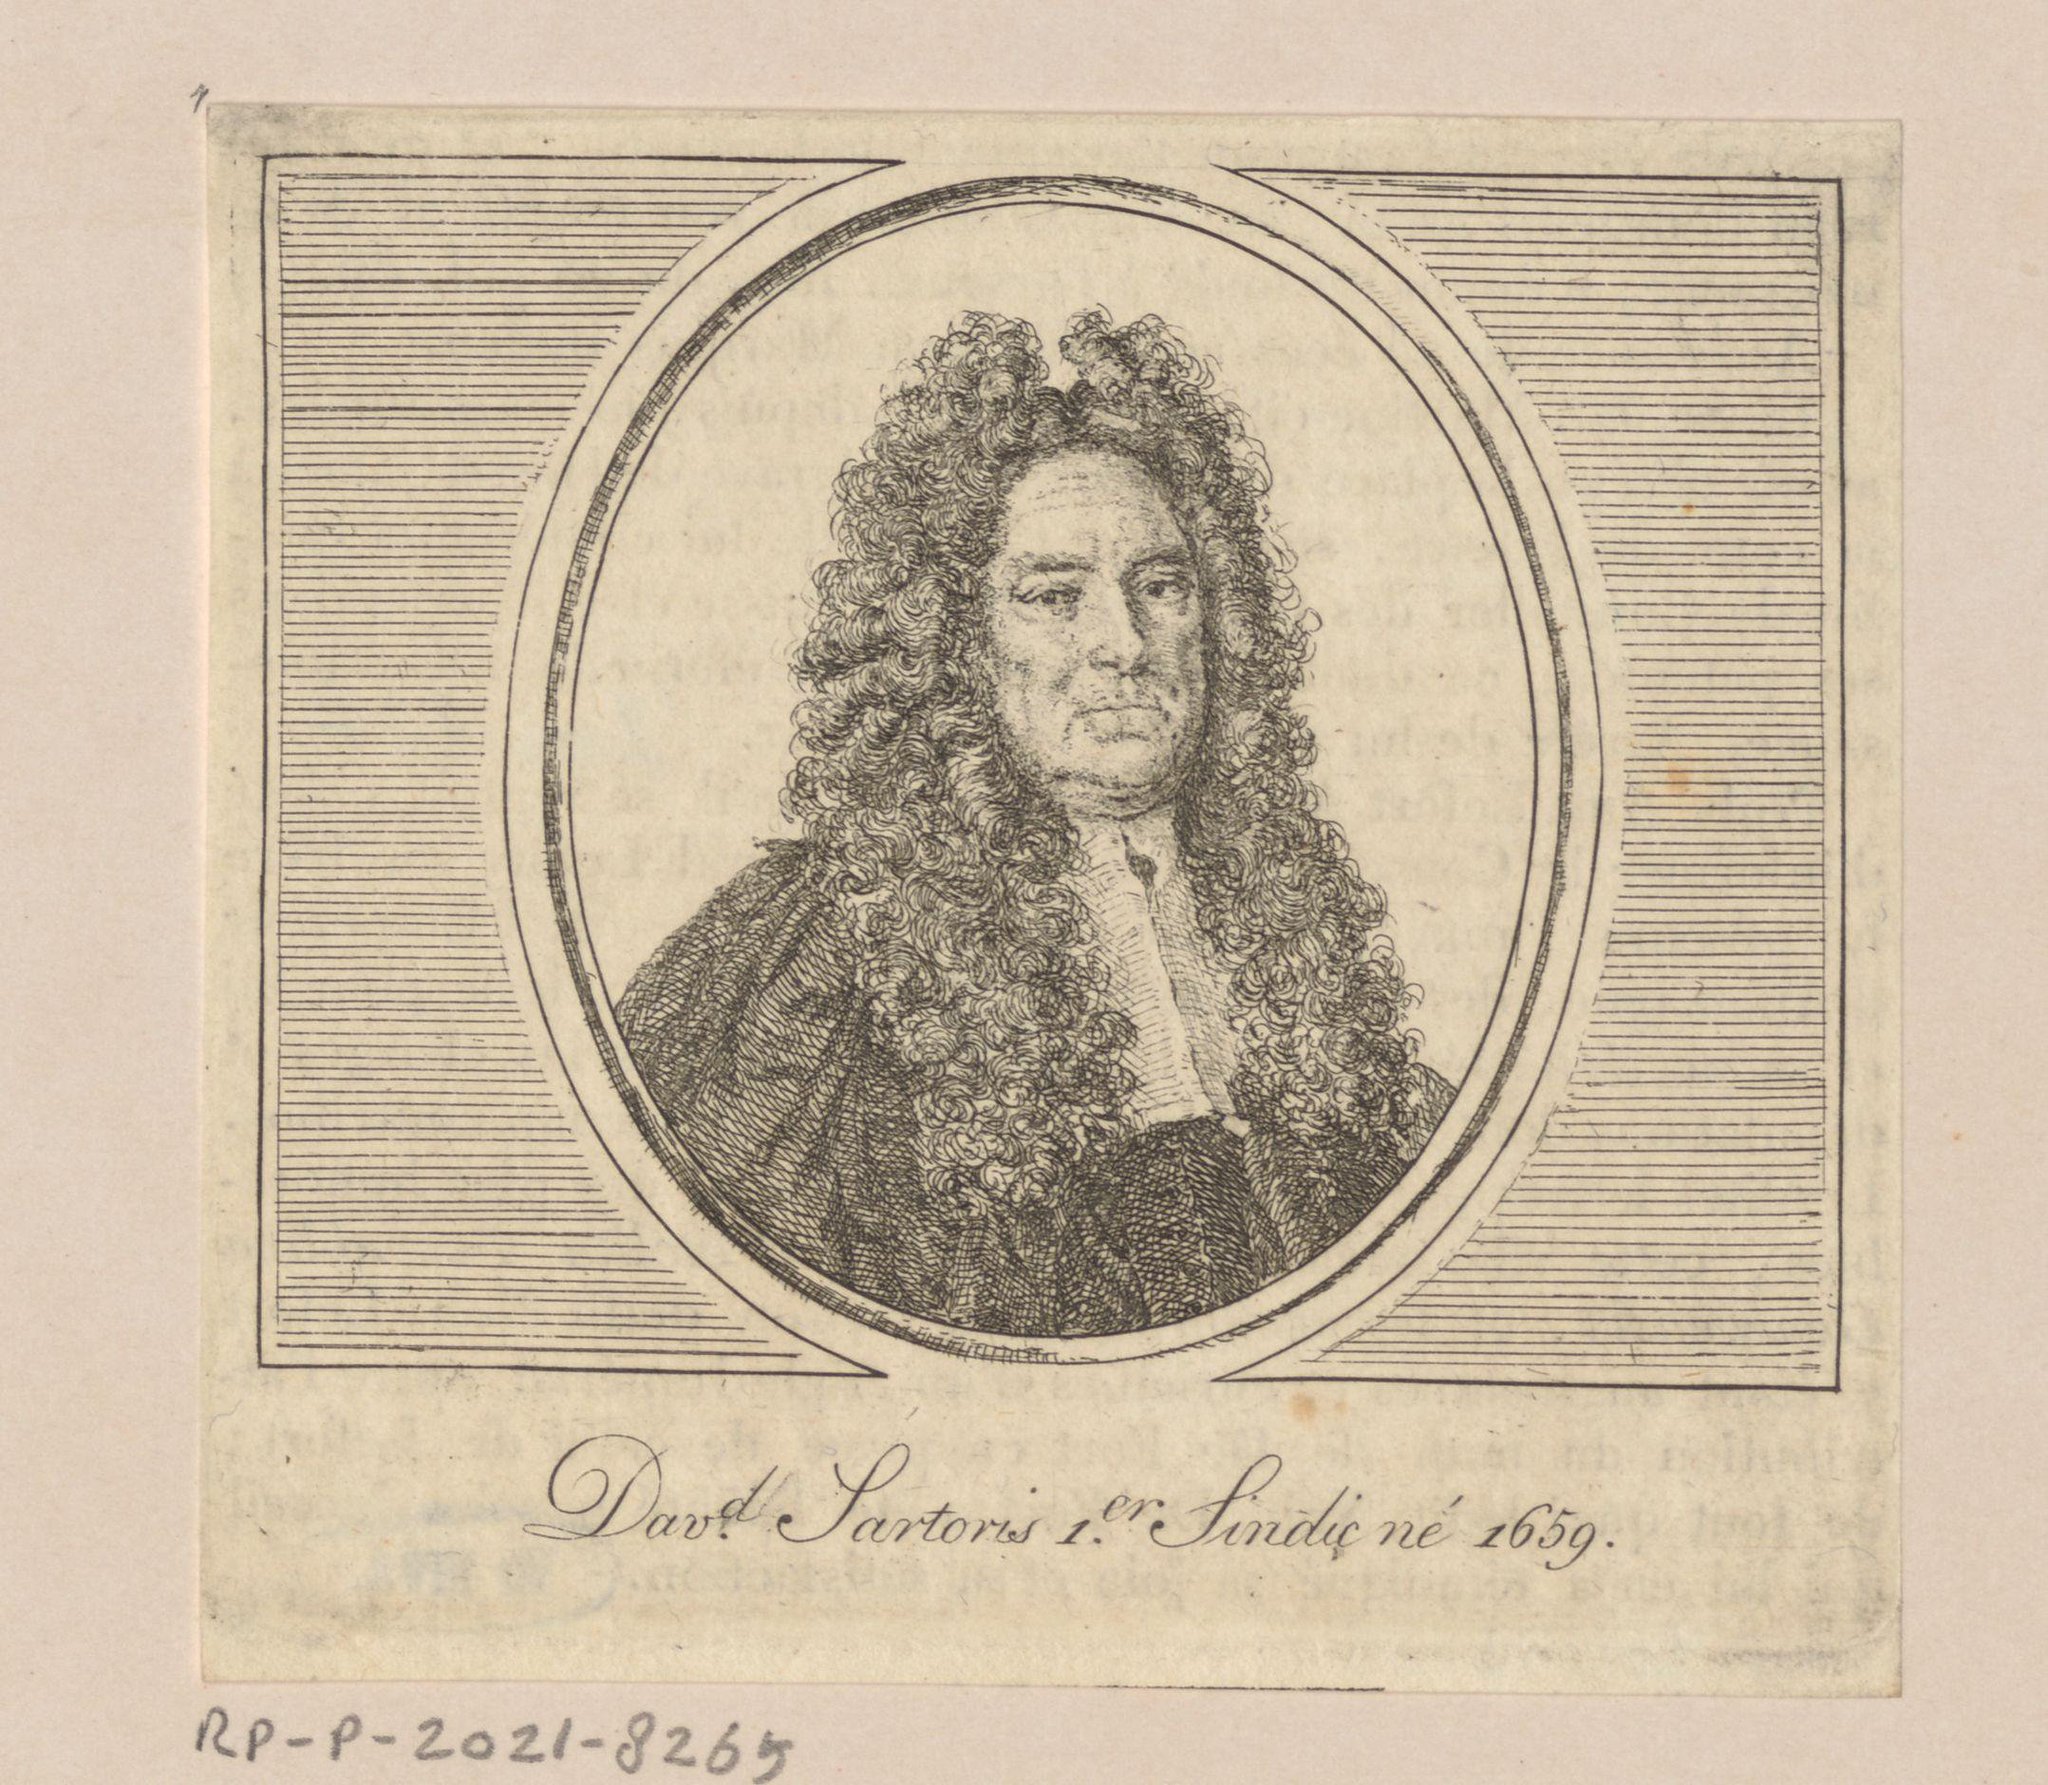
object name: book illustration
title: Portret van David Sartoris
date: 1815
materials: paper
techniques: etching, letterpress printing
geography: geneva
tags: historical persons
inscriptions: collector's mark: Lugt 2228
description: Prent uit: Grenus, Théodore de. Fragmens biographiques et historiques. Extraits des registres du Conseil (...). Genève: Manget et Cherbuliez, 1815.